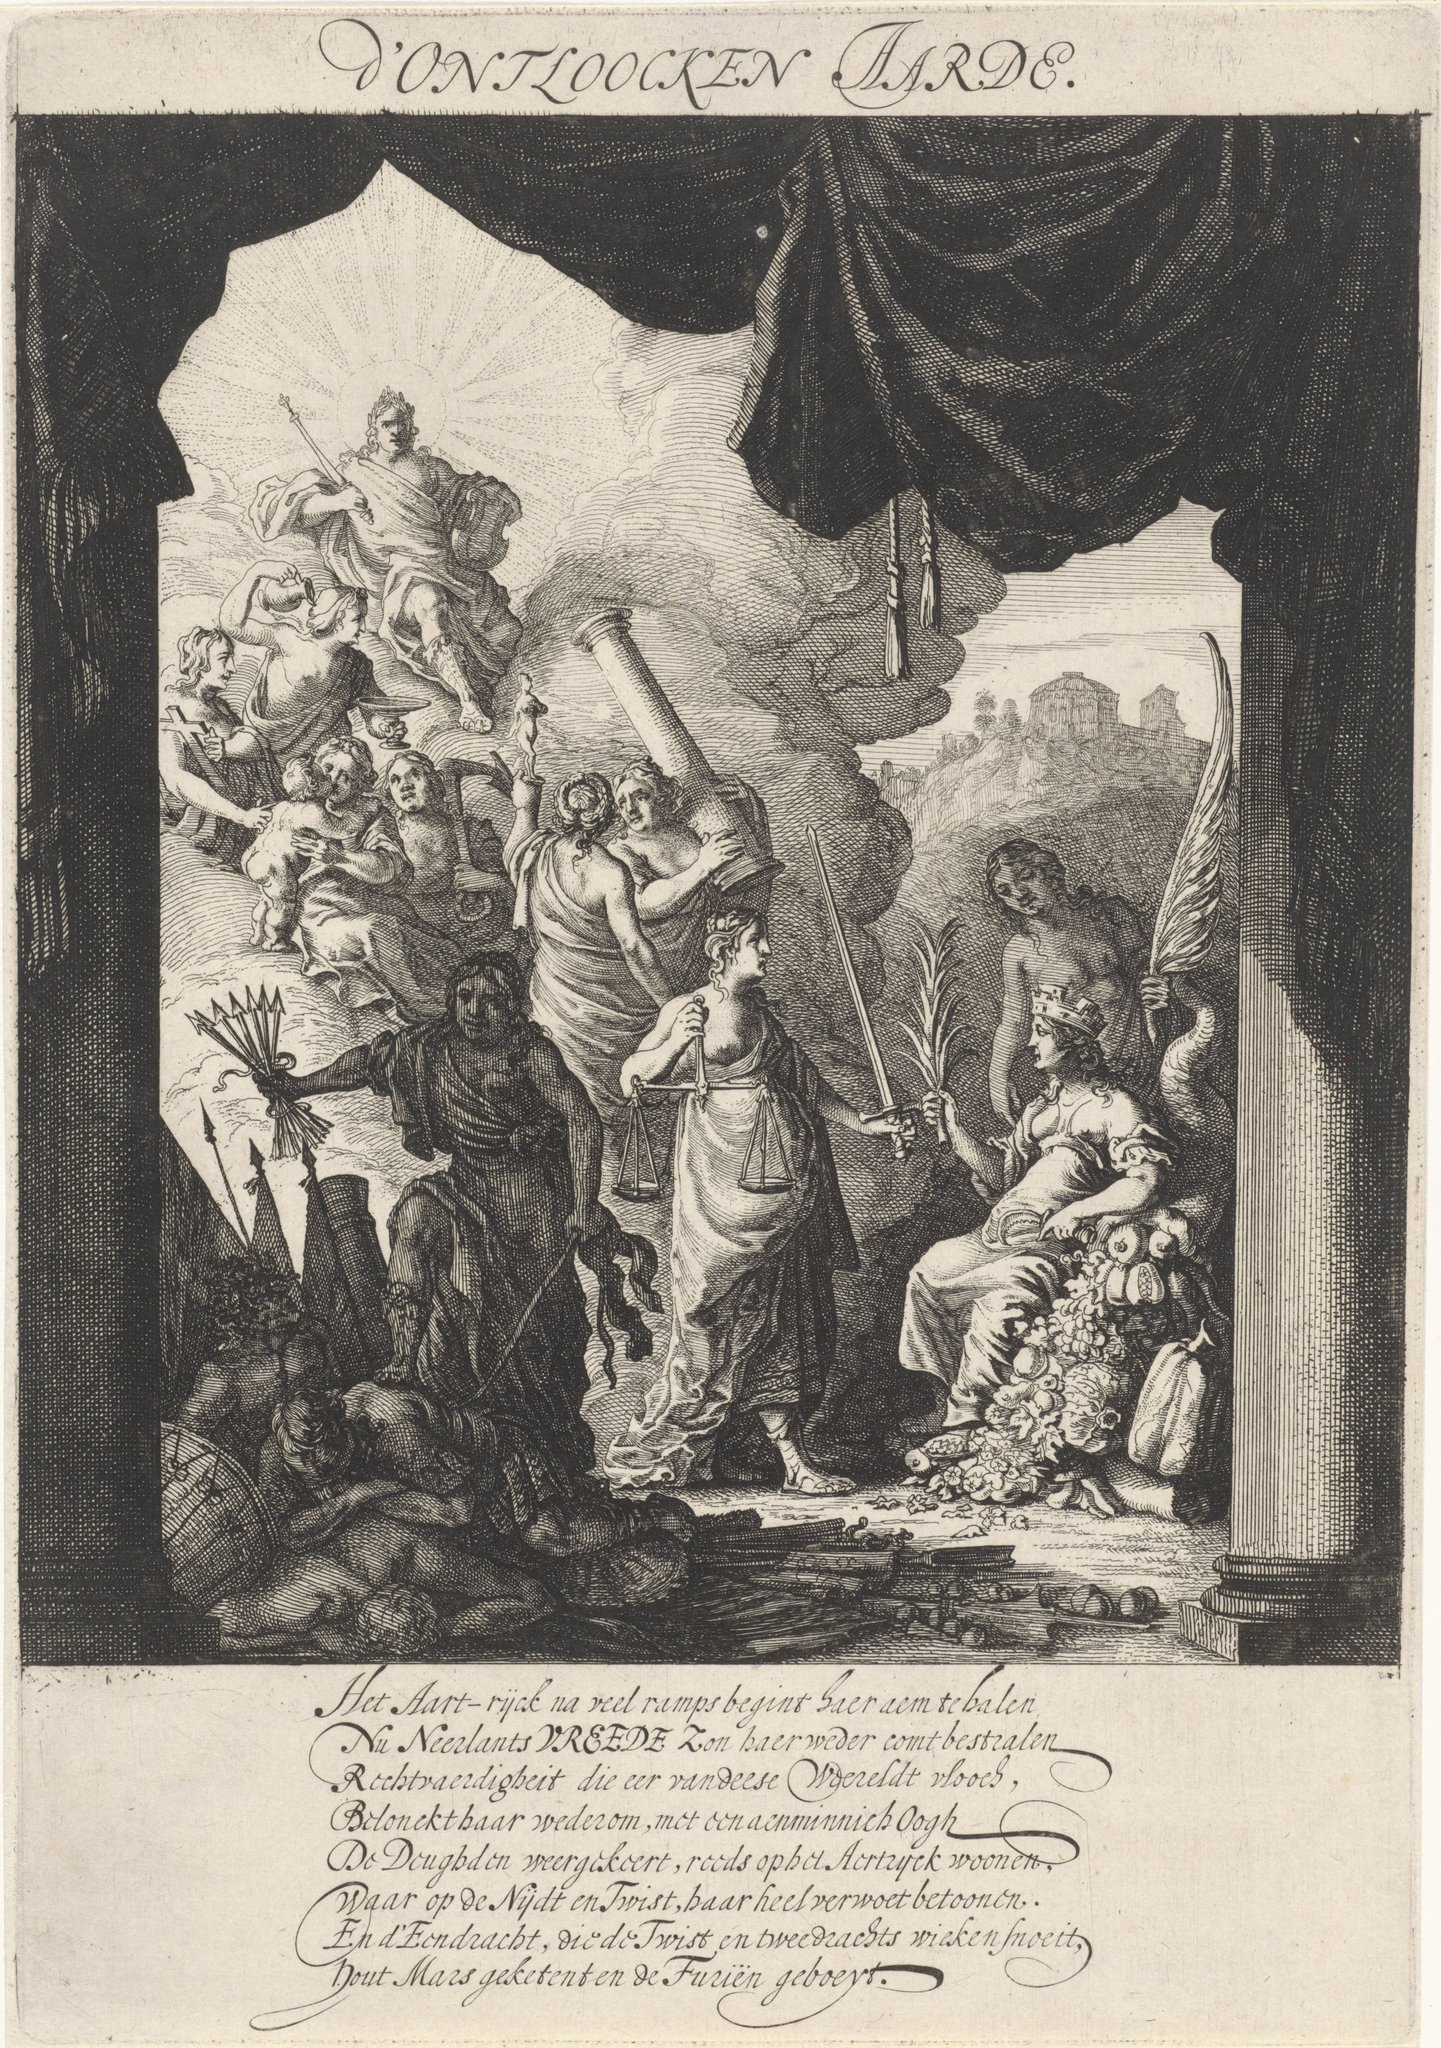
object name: print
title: d'Ontloocken Aarde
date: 1649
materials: paper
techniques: etching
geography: amsterdam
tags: theatre, theatrical performance, the seven virtues (symbolized), festivities on events of national importance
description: Vertoning van het Ontluiken van de Aarde. Onderdeel van de vertoningen opgevoerd op 23 juni 1648 op de Schouwburg te Amsterdam naar aanleiding van het sluiten van de Vrede van Munster. De vierde voorstelling toont hoe de Aarde en de Overvloed zich weer herstelt na de oorlog, de deugden keren vanuit de godenhemel (met Apollo) weer terug op de aarde. In het onderschrift een vers van 8 regels in het Nederlands.